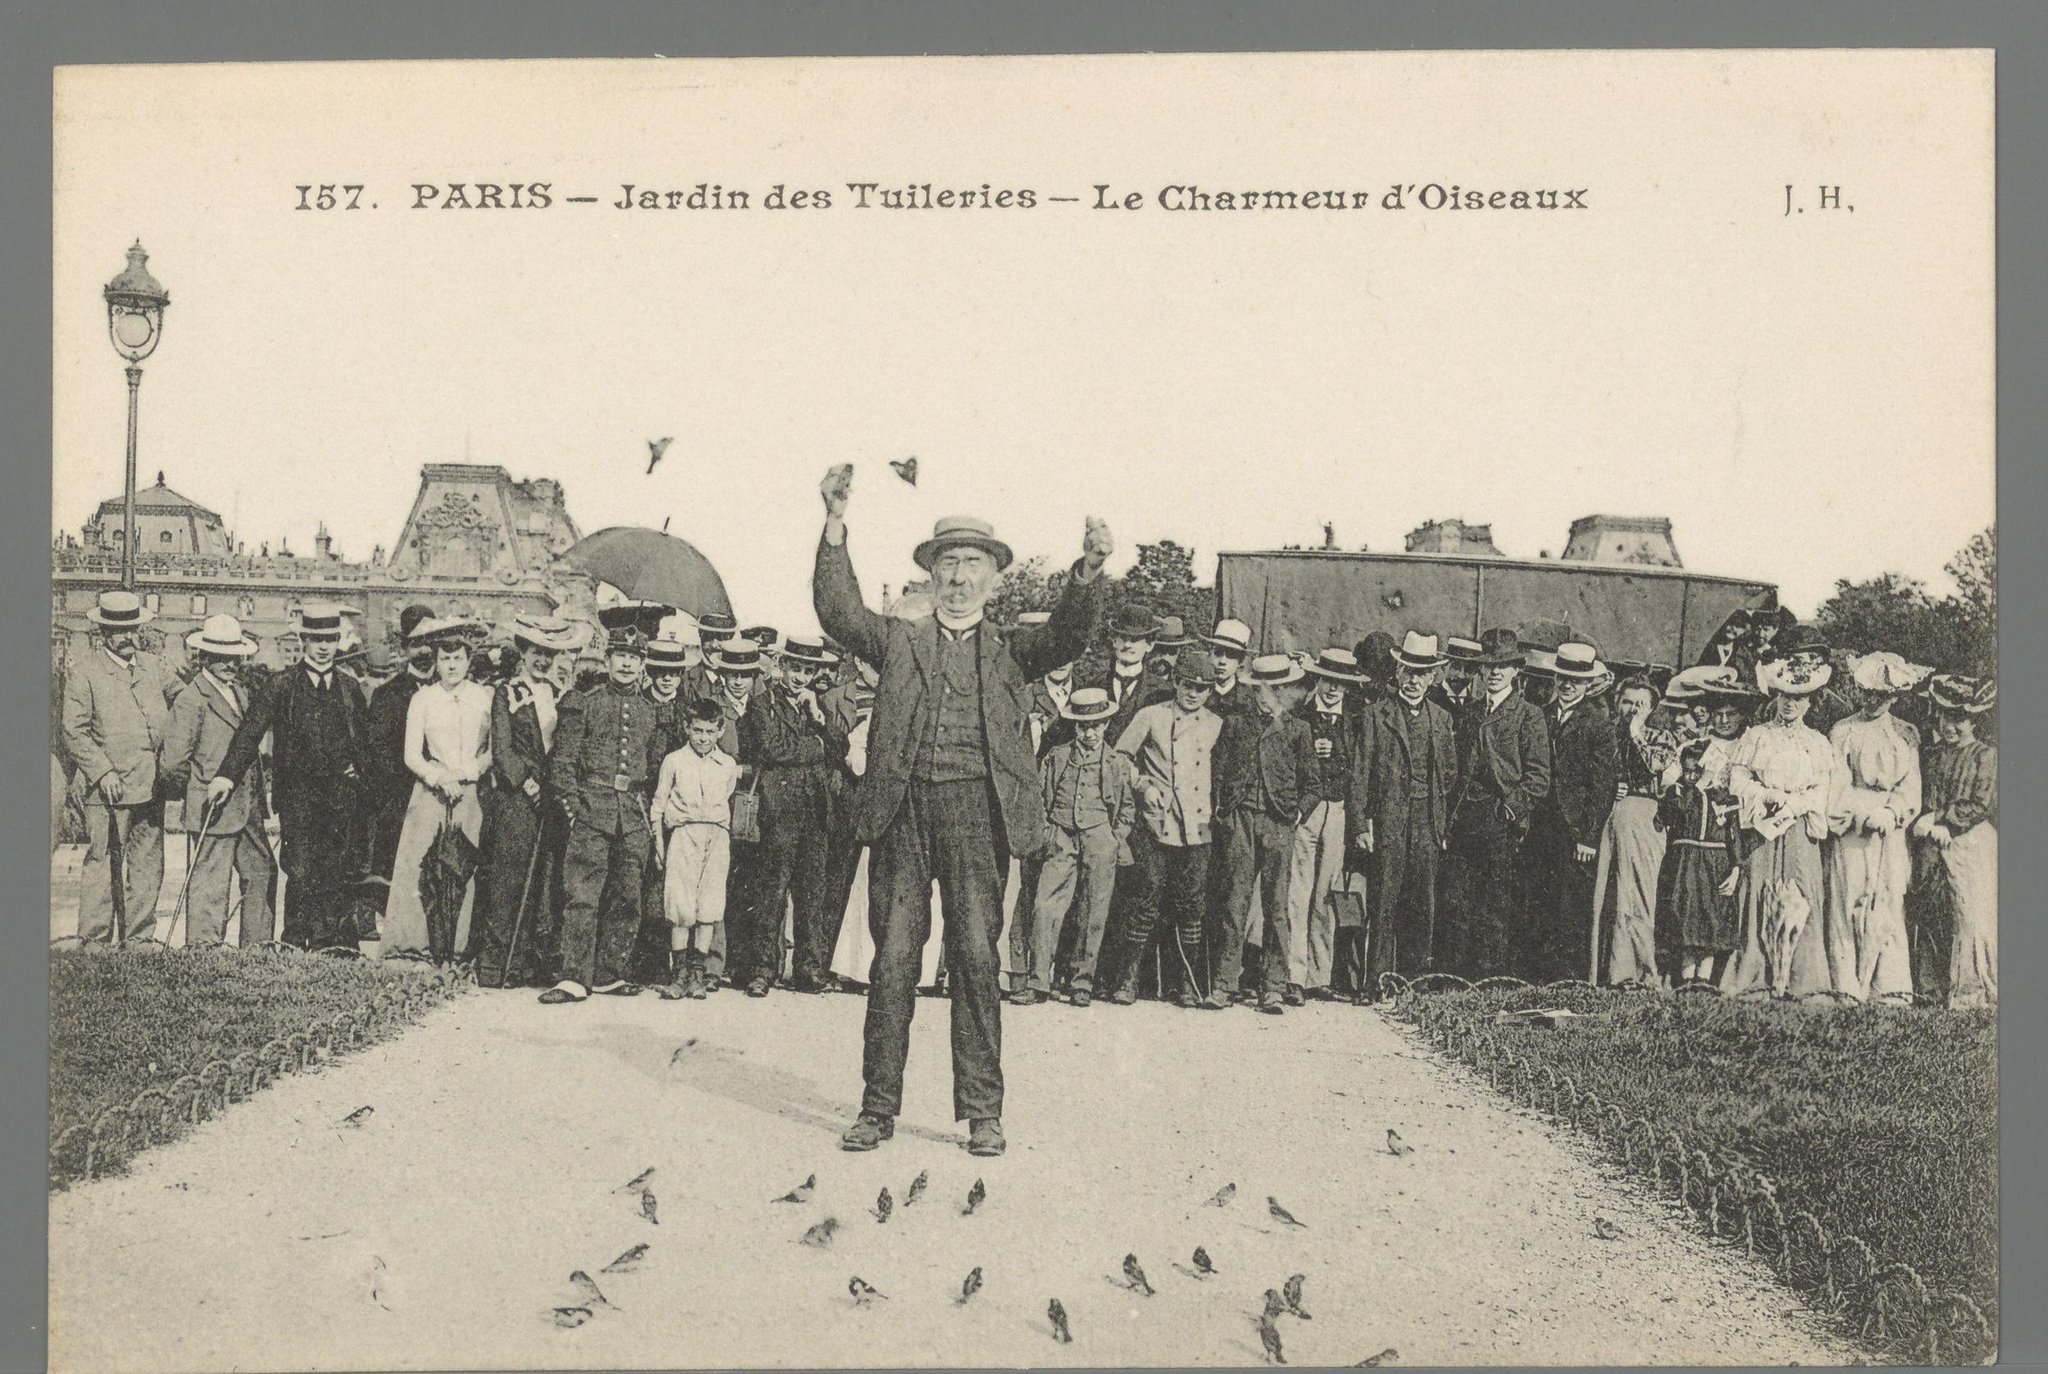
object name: ansichtkaart, prentbriefkaart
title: Paris. Jardin des Tuileries. Le Charmeur d'Oiseaux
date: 1903-1908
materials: cardboard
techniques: photograph, writing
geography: paris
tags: performance, public gardens, park (+ city(-scape) with figures, staffage), birds